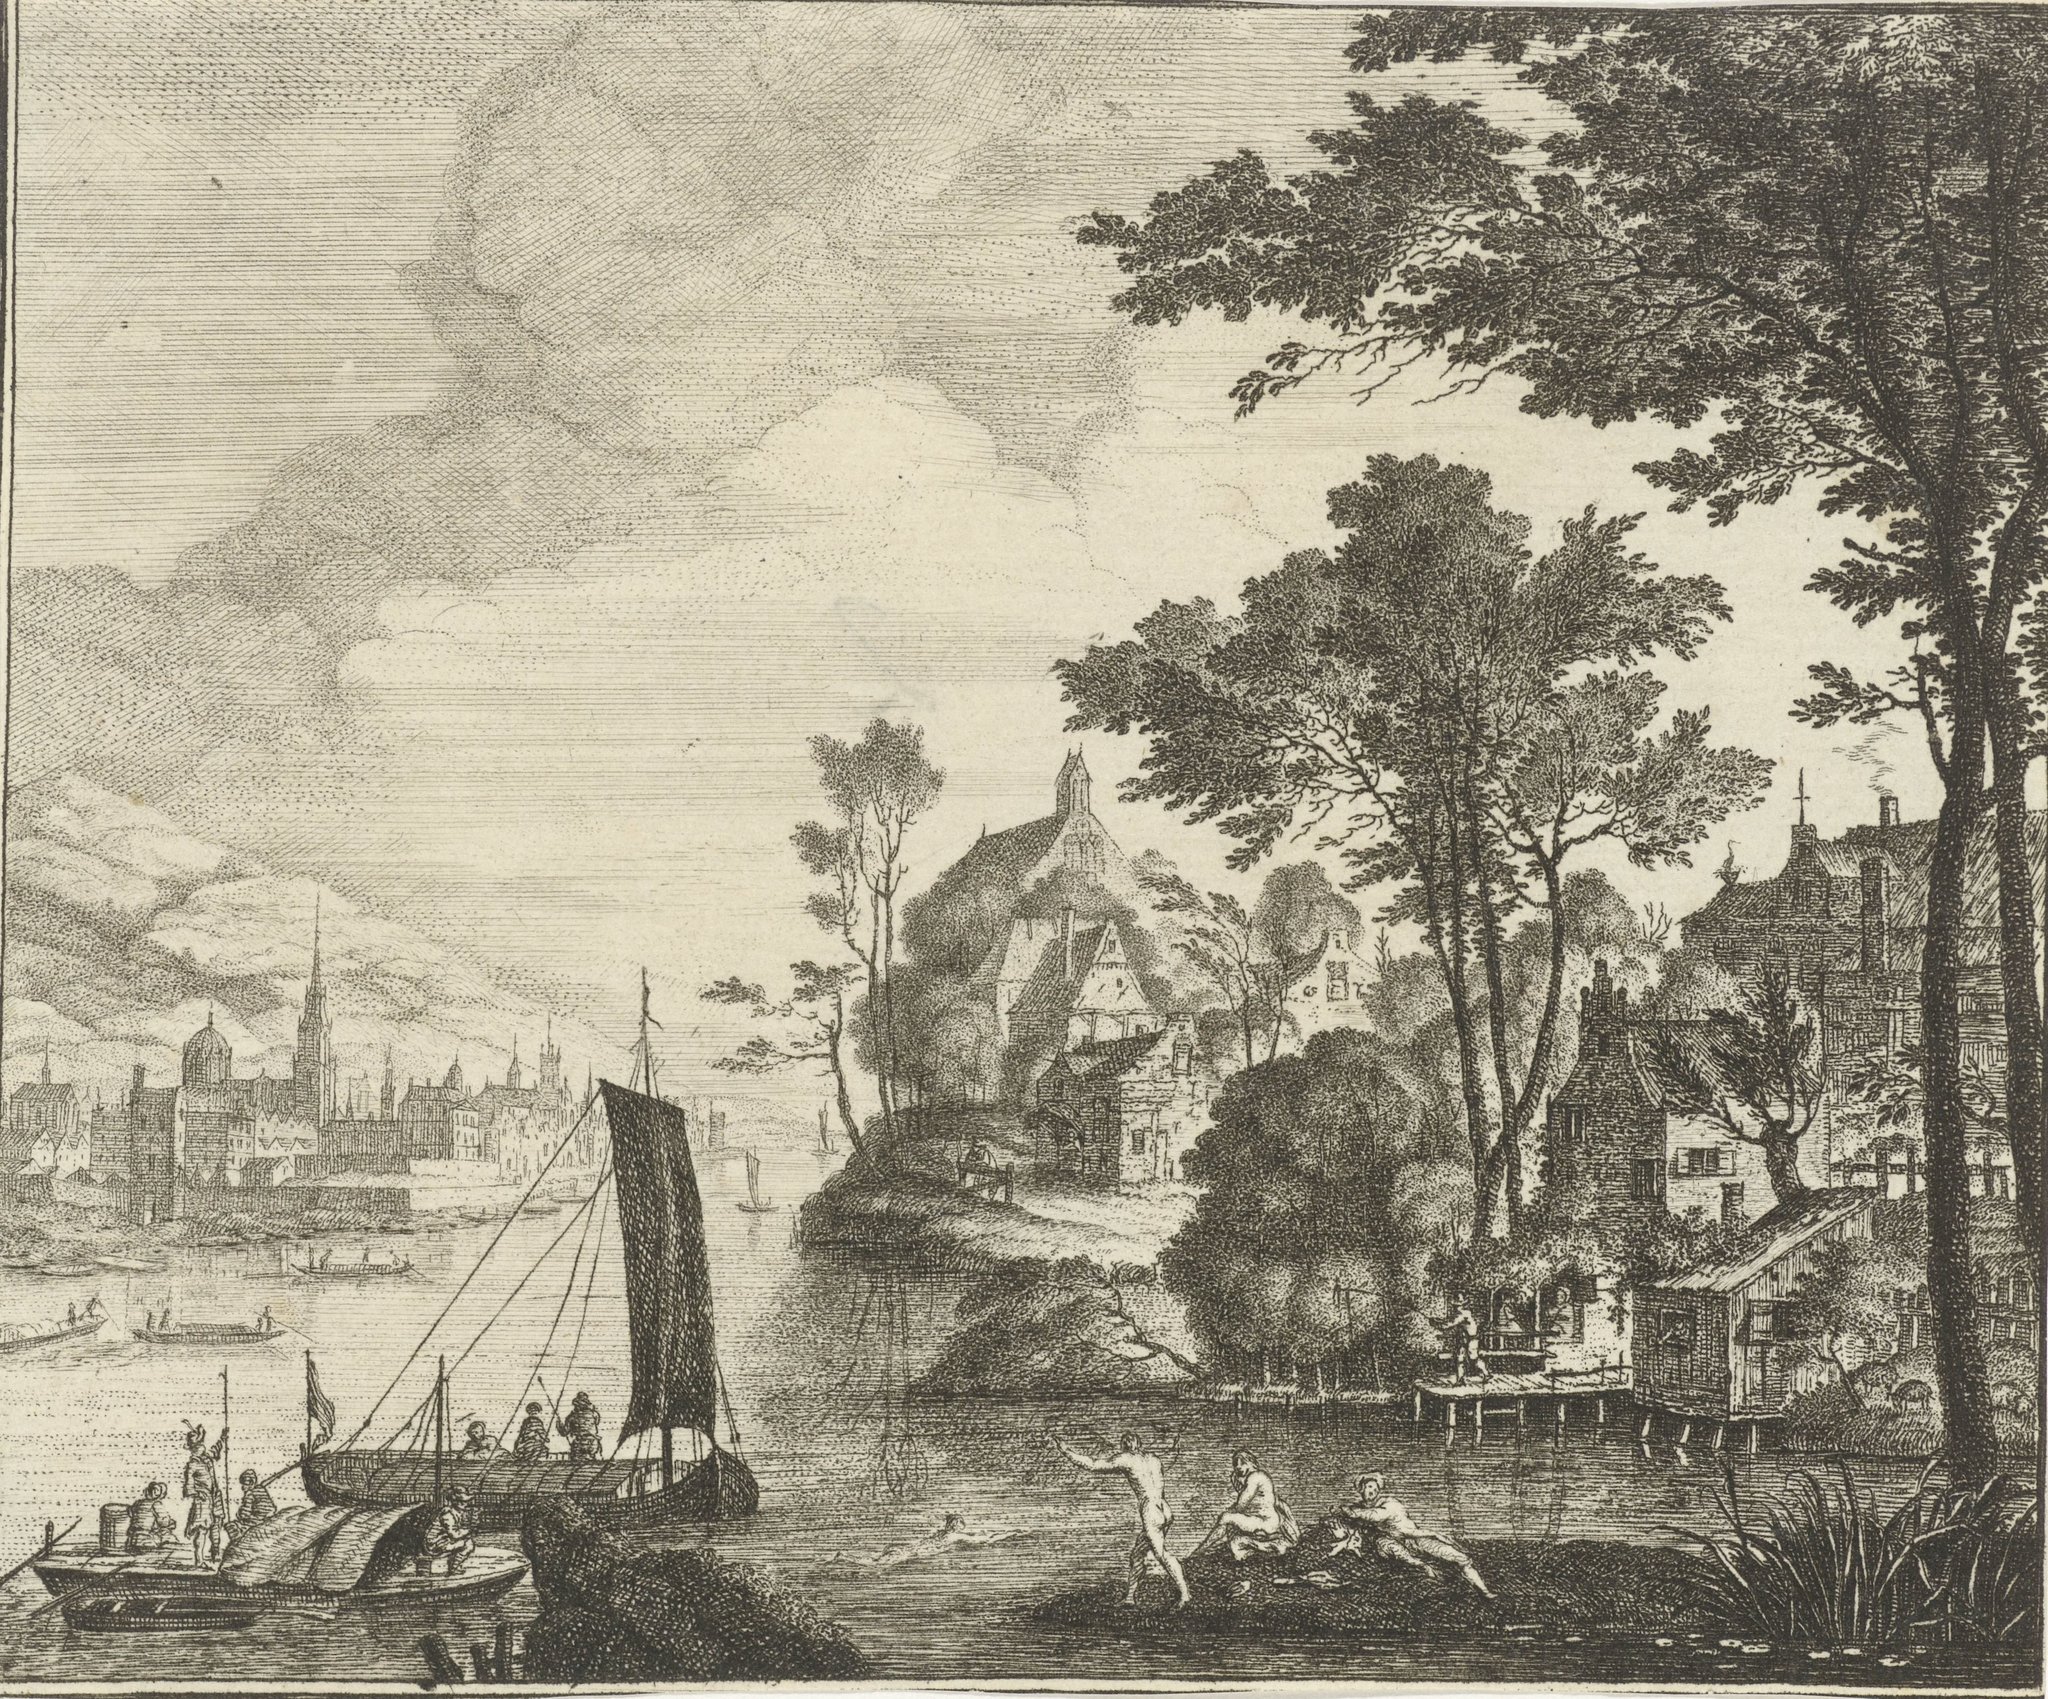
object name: print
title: Rivierlandschap met zwemmers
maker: gerard melder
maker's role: painter, print maker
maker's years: 1693-1754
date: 1703-1754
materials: paper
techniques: etching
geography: utrecht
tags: water course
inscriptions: collector's mark: Lugt 2165